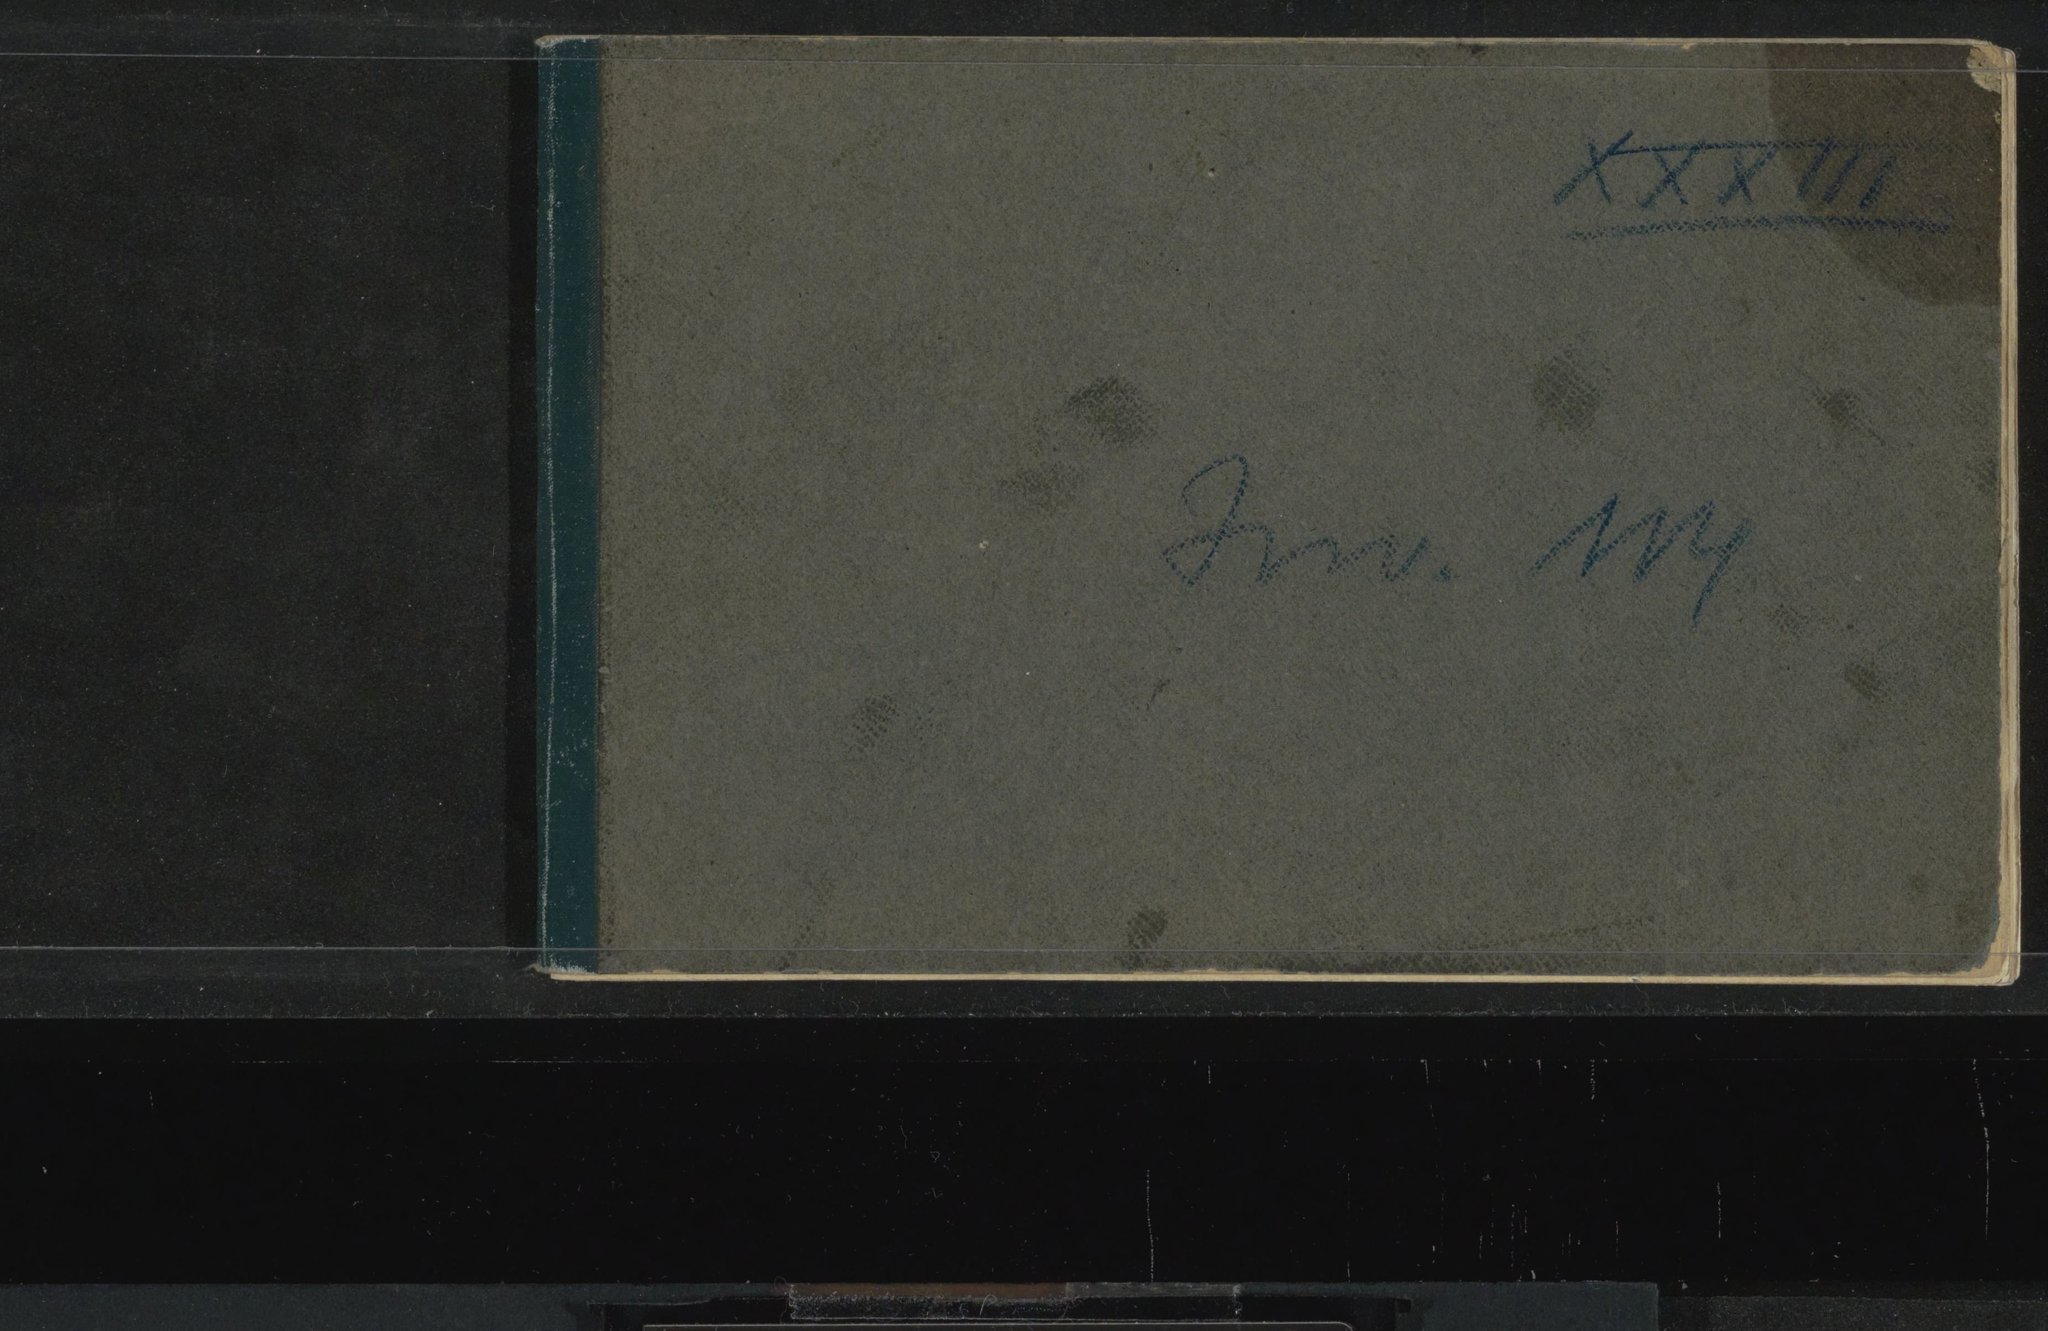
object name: sketchbook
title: Schetsboek XXXIII met 47 pagina's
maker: isaac israels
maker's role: draughtsman, painter, print maker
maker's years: 1865-1934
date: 1886-1903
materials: cardboard, chalk, linen, paper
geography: amsterdam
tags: adult woman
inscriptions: collector's mark: Lugt 2228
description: Pagina's 3, 4, 7, 8, 25, 26, 29 t/m 32, 37, 38 en 43 t/m 47 zijn blanco en daarom niet beschreven.